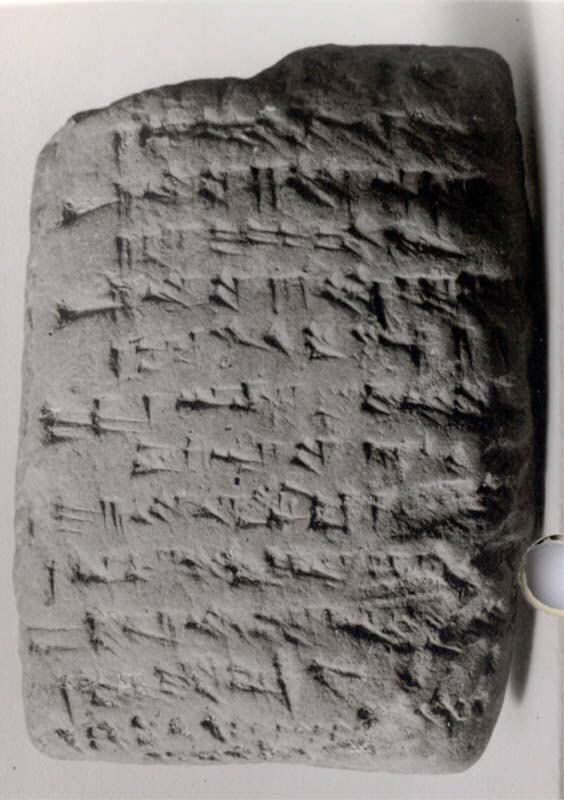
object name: cuneiform tablet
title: Cuneiform tablet: account of barley disbursements, Ebabbar archive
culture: babylonian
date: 700-501 BCE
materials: clay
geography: mesopotamia